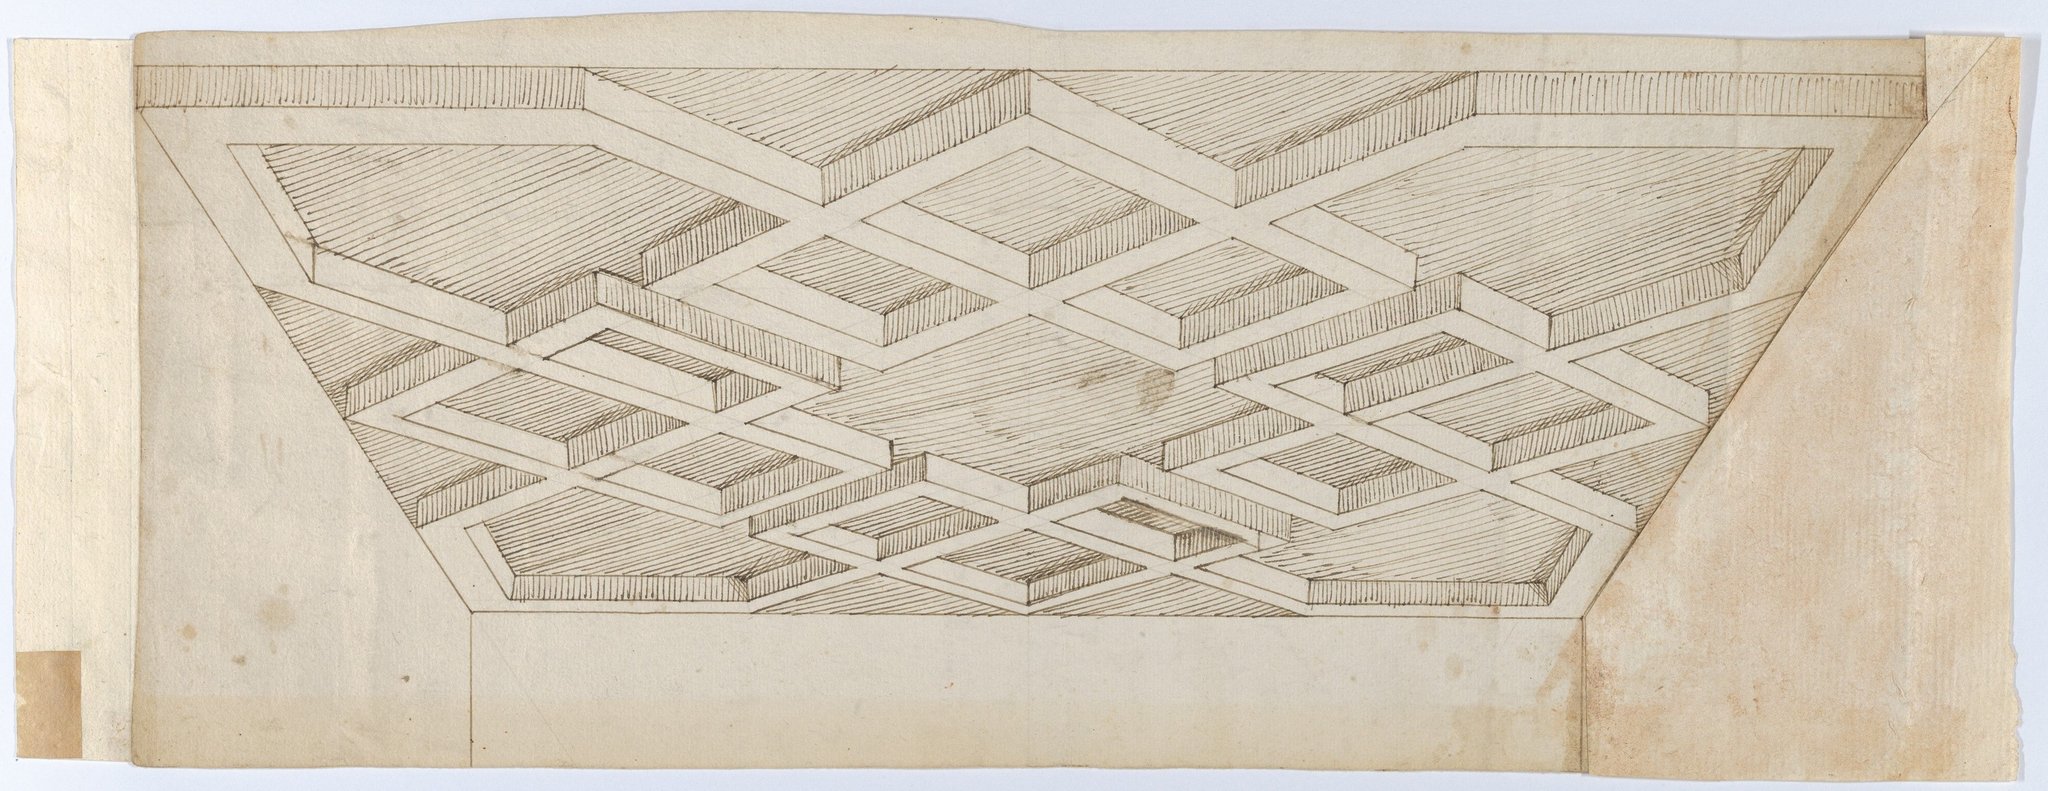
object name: drawing ornament architecture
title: Three Design for Ornament & Architecture: Perspectival Rendering of a Ceiling; Two Sheets of Rocaille Designs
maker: anonymous, italian, 16th century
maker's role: artist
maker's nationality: italian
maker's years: 1500-1600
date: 1730-1760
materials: ink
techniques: pen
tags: architecture